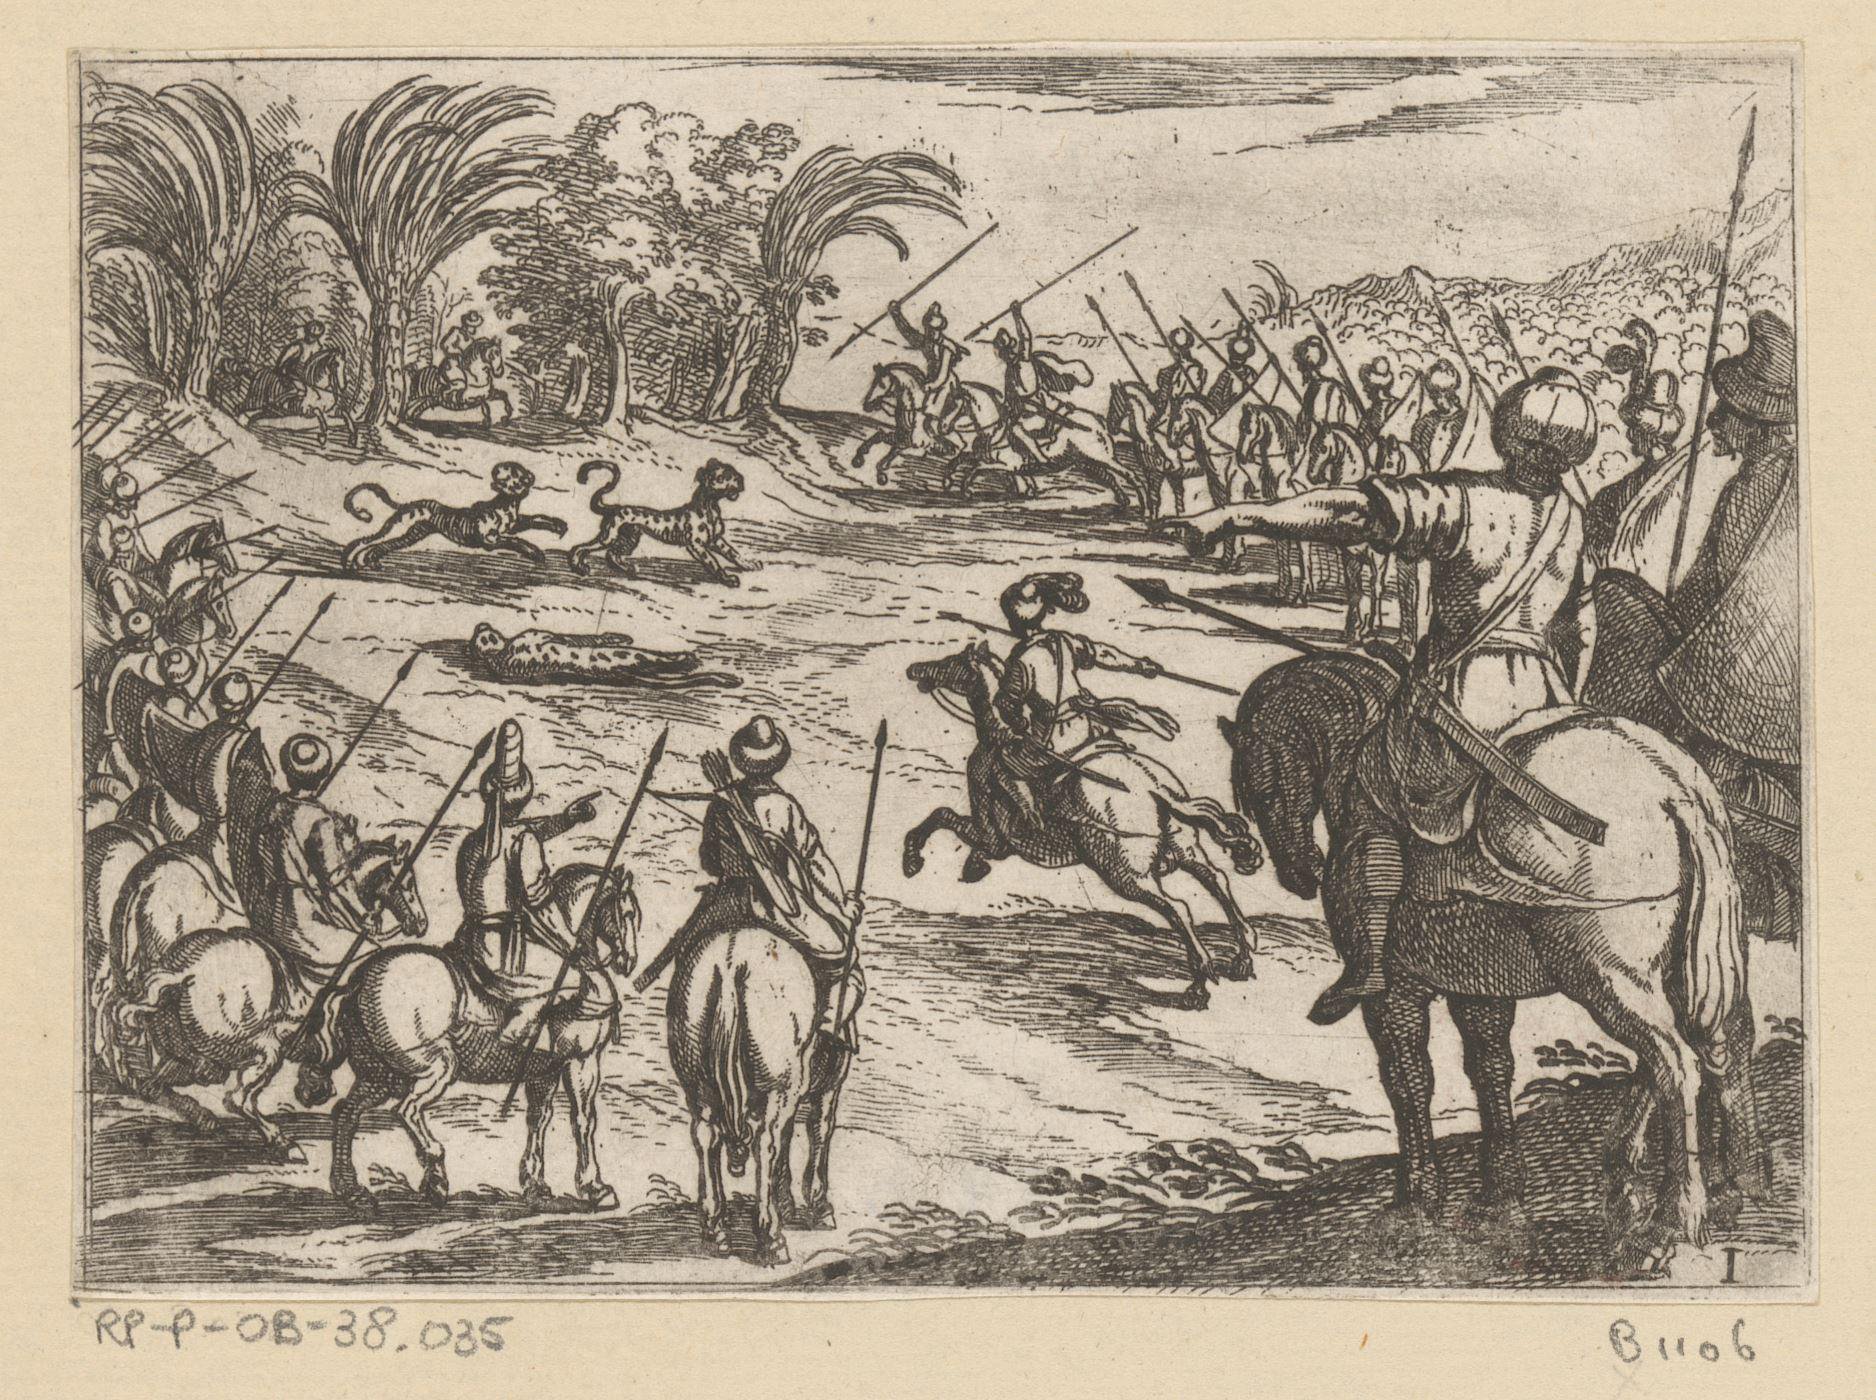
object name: print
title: Jachtscènes (deel 3)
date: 1598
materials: paper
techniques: etching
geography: italy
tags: beasts of prey, predatory animals: tiger, beasts of prey, predatory animals: leopard, hunter, hunters hunting (n.b.: in 1988-1990 this notation denoted the concept of 43c11421 'hunters resting during the hunt')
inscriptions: collector's mark: Lugt 240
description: Deze prent maakt deel uit van een reeks van vijftien prenten met jachtscènes (+ opdracht).